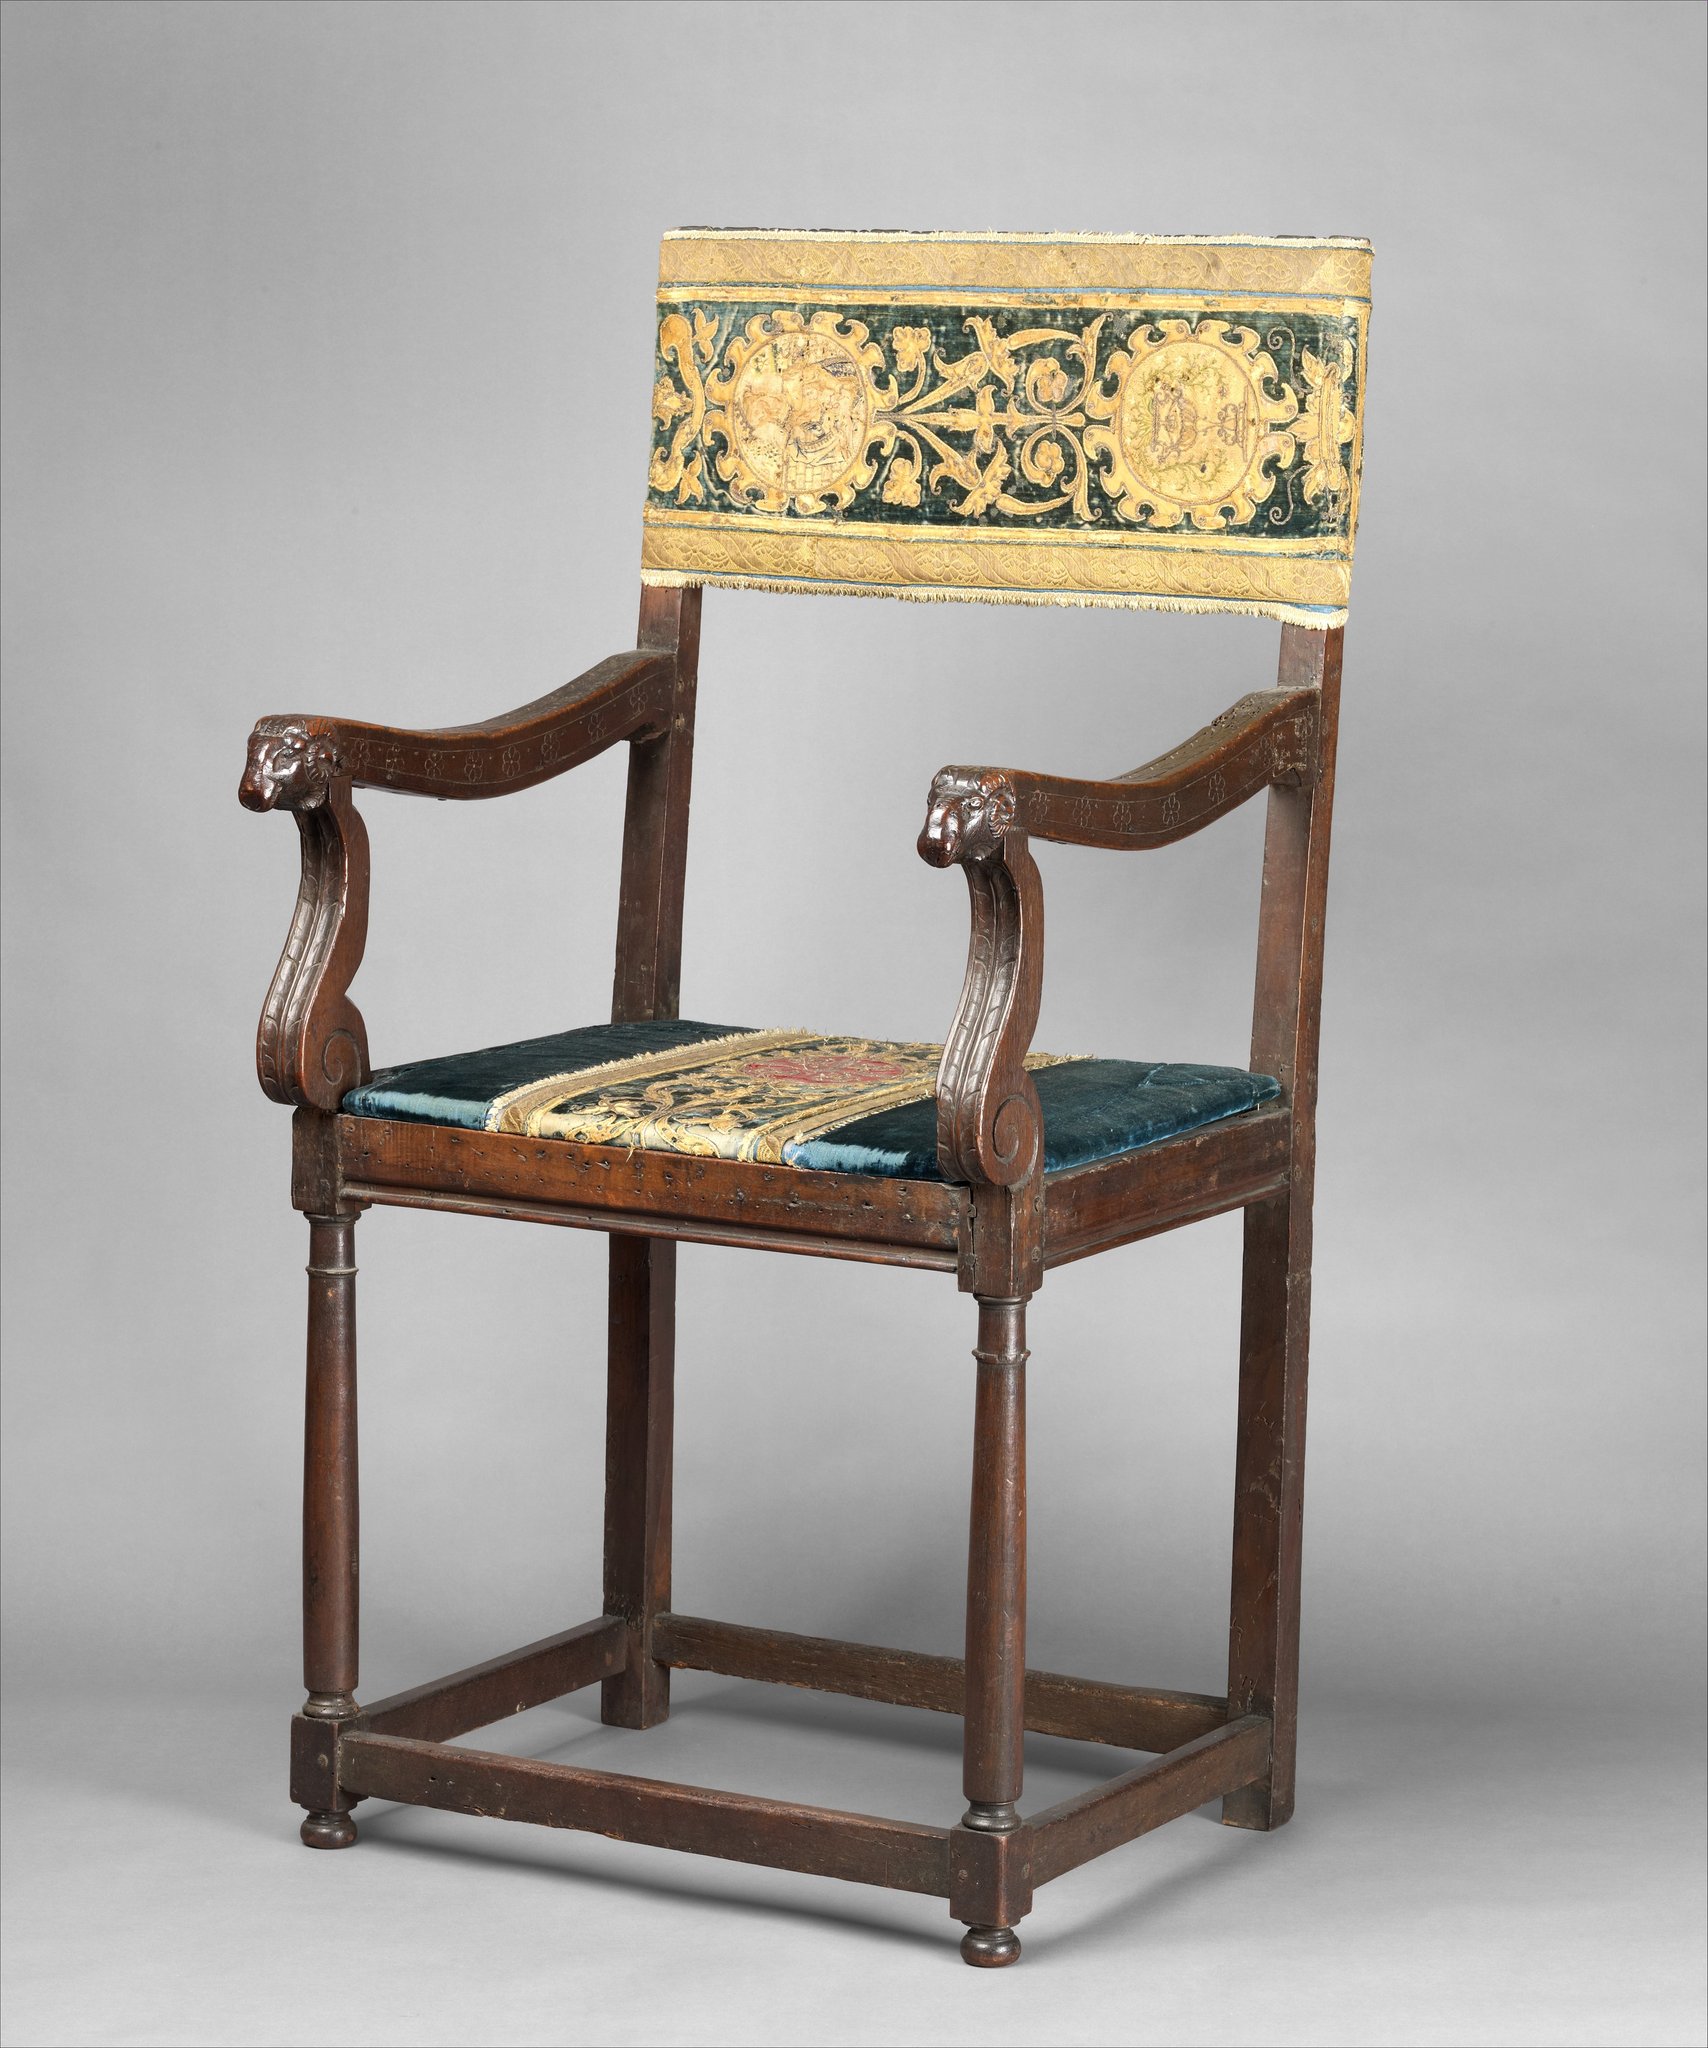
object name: armchair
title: Armchair (chaise à bras, pair with 1975.1.2001)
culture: french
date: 1501-1600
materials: silk, velvet, wood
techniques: carving, cutting, embroidery